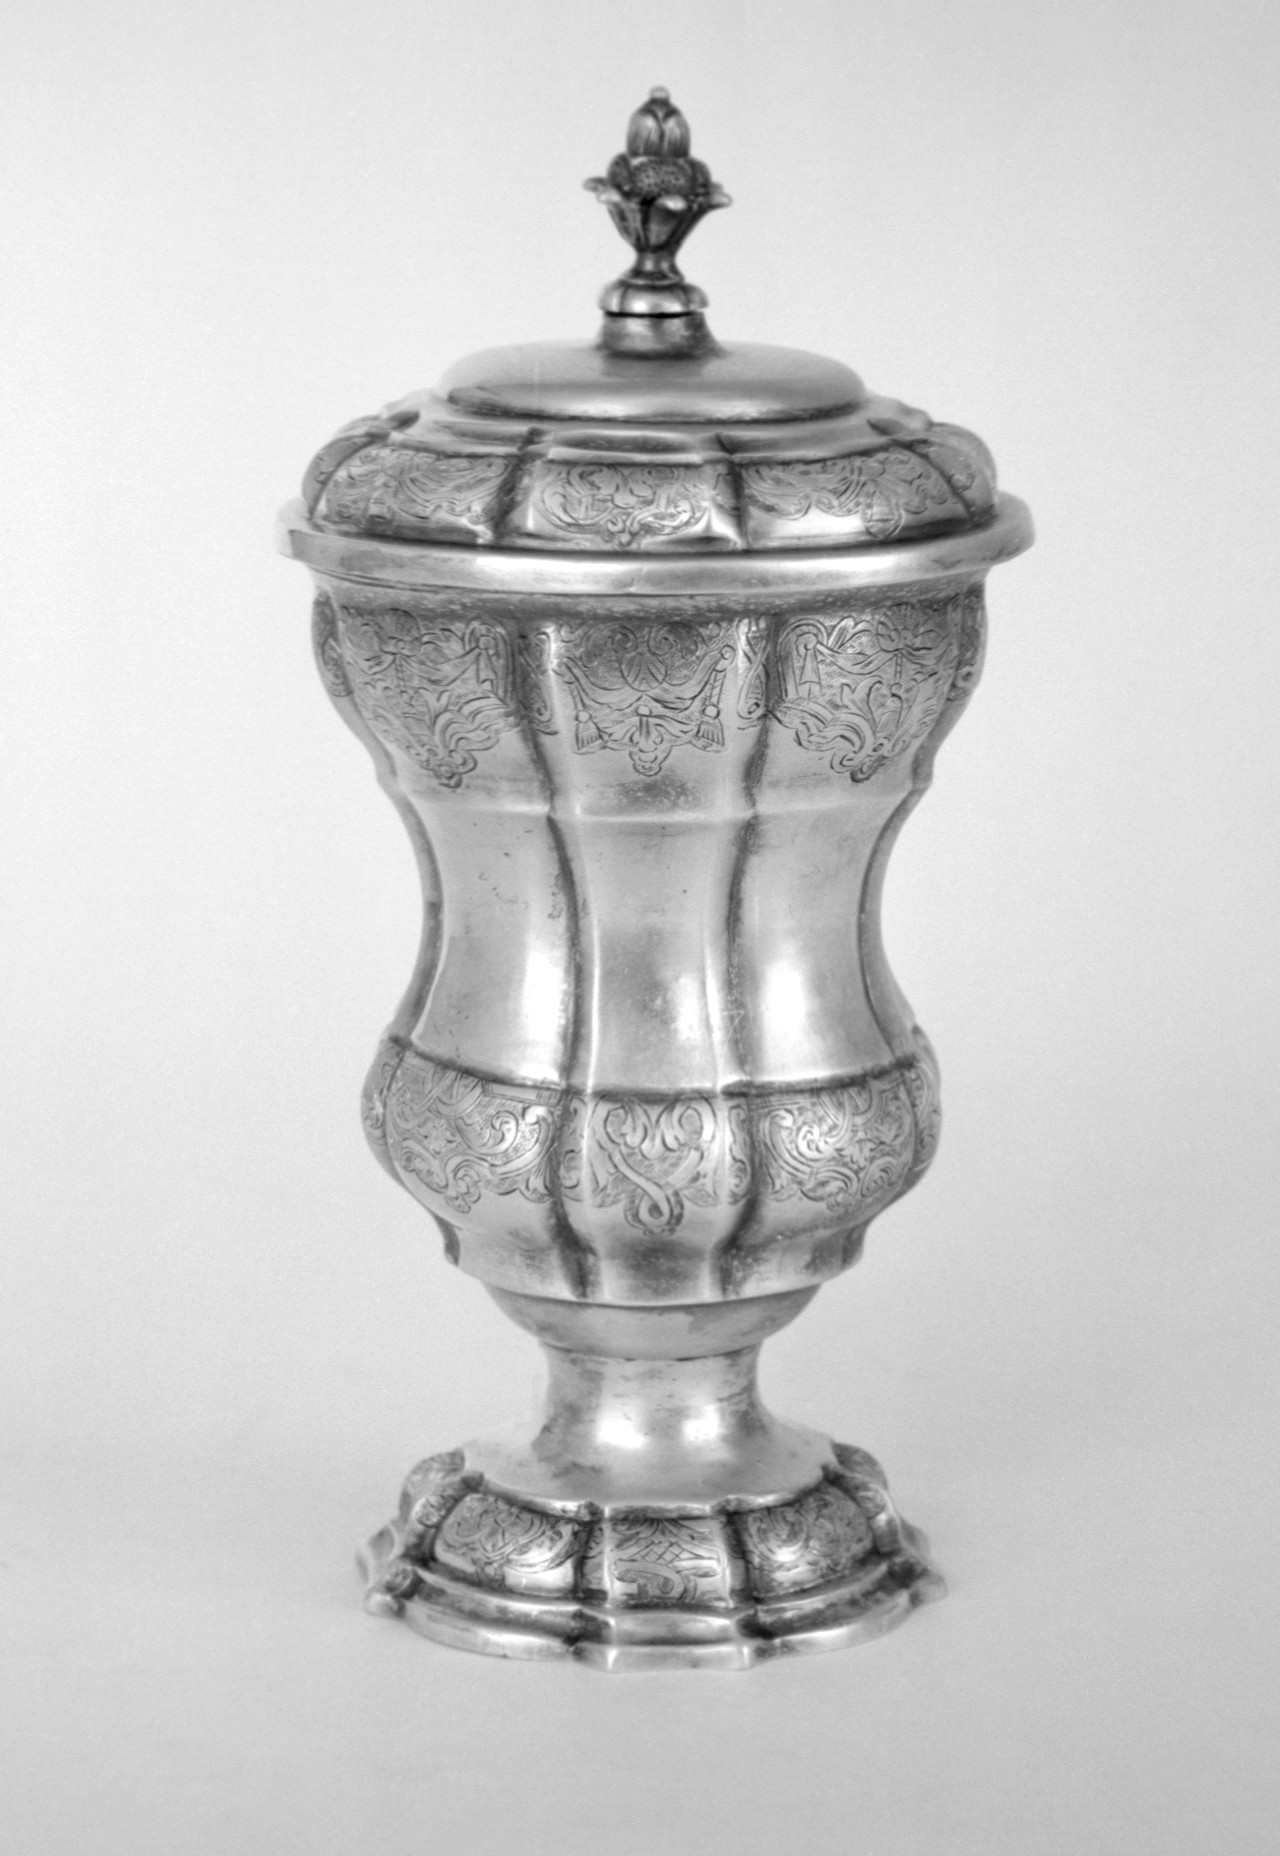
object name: cup with cover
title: Thistle-shaped cup with cover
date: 1714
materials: silver gilt